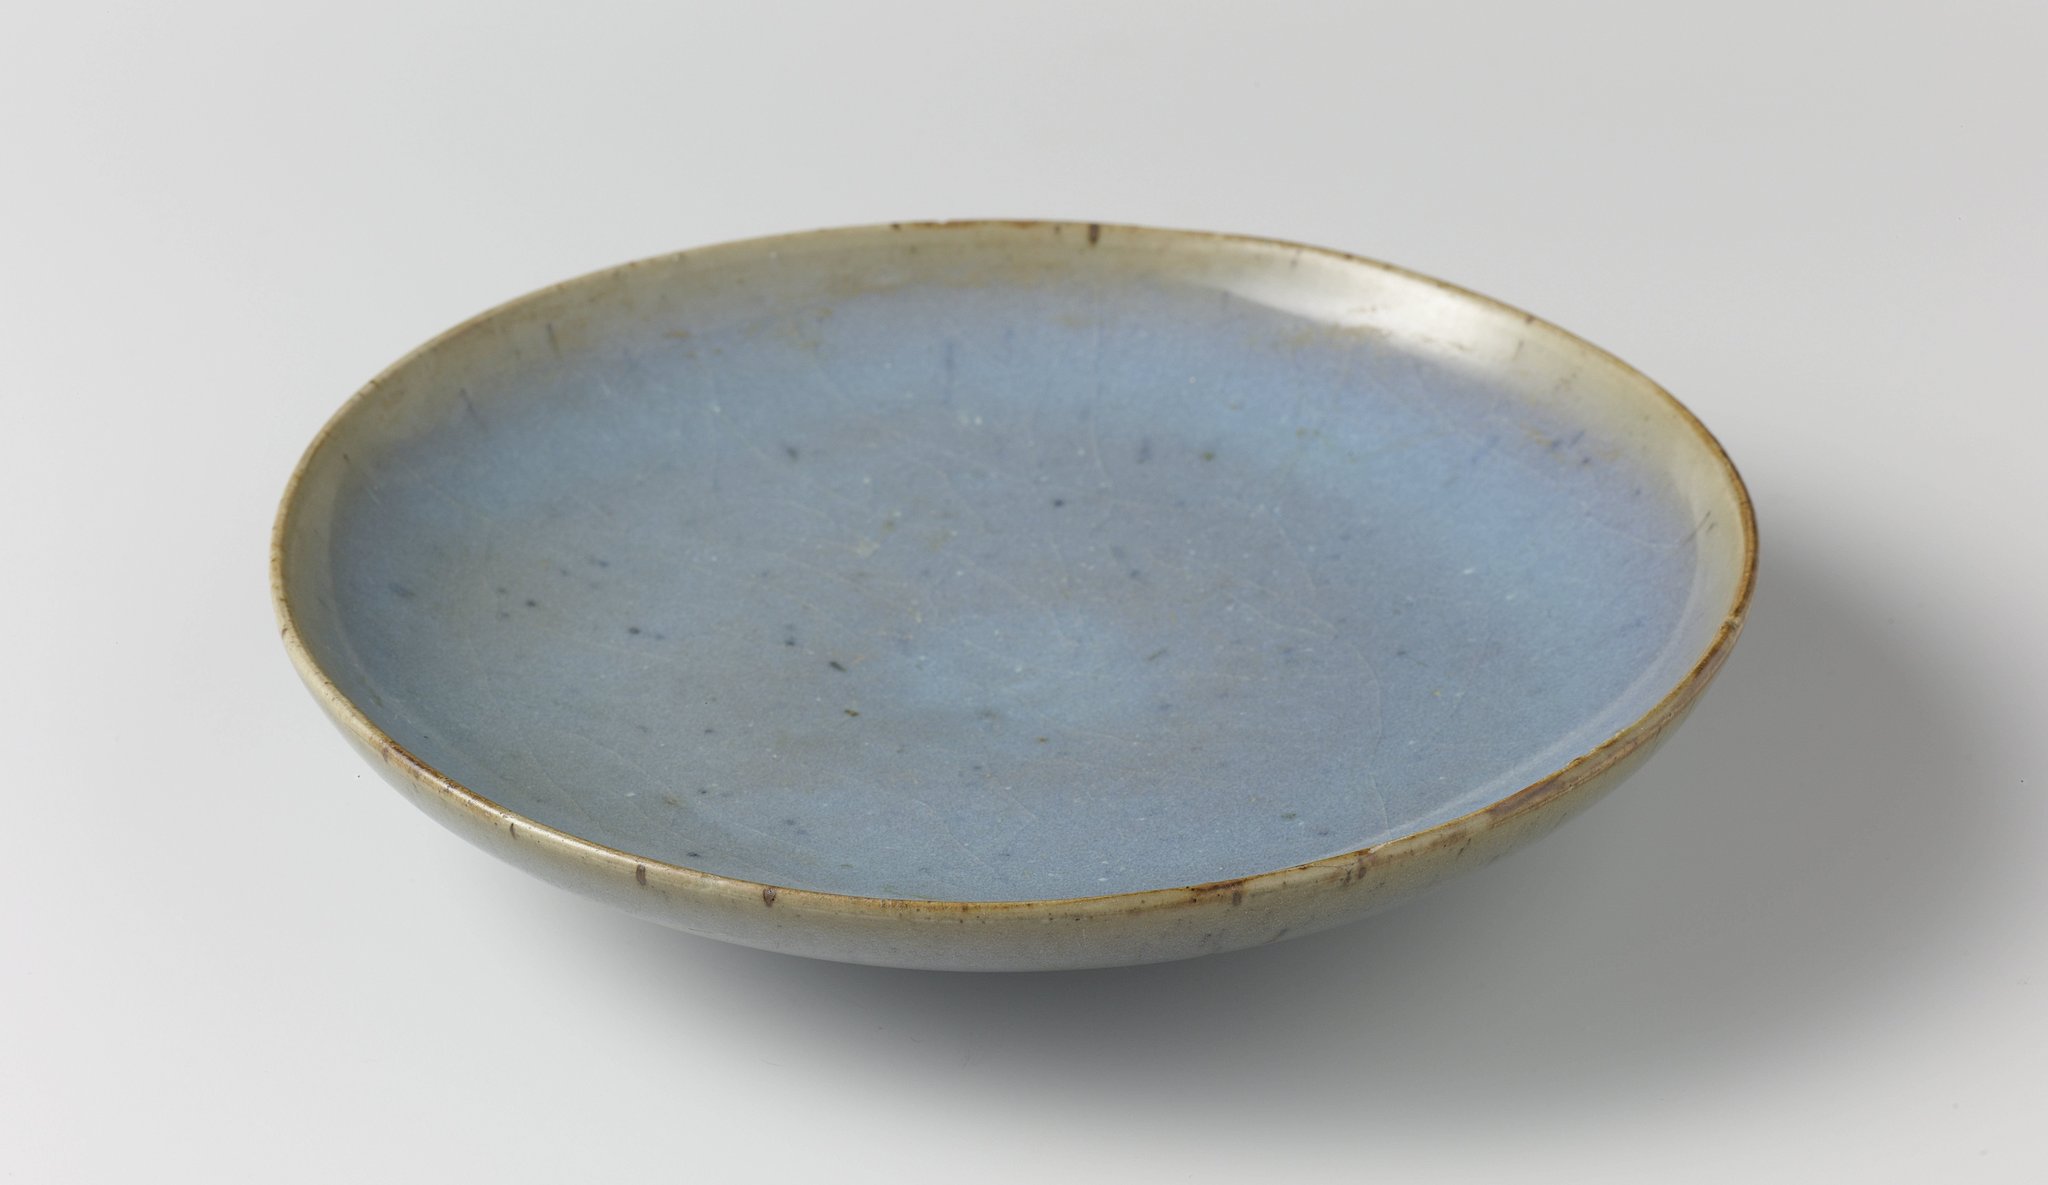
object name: dish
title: Dish with a lavender blue glaze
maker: Anonymous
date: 1100-1300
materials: glaze, stoneware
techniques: firing, turning, vitrification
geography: china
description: Schaal van steengoed, bedekt met een lavendelblauw, licht gecraqueleerd glazuur. Naar de rand verandert de kleur naar een geelbruine tint. Jun.